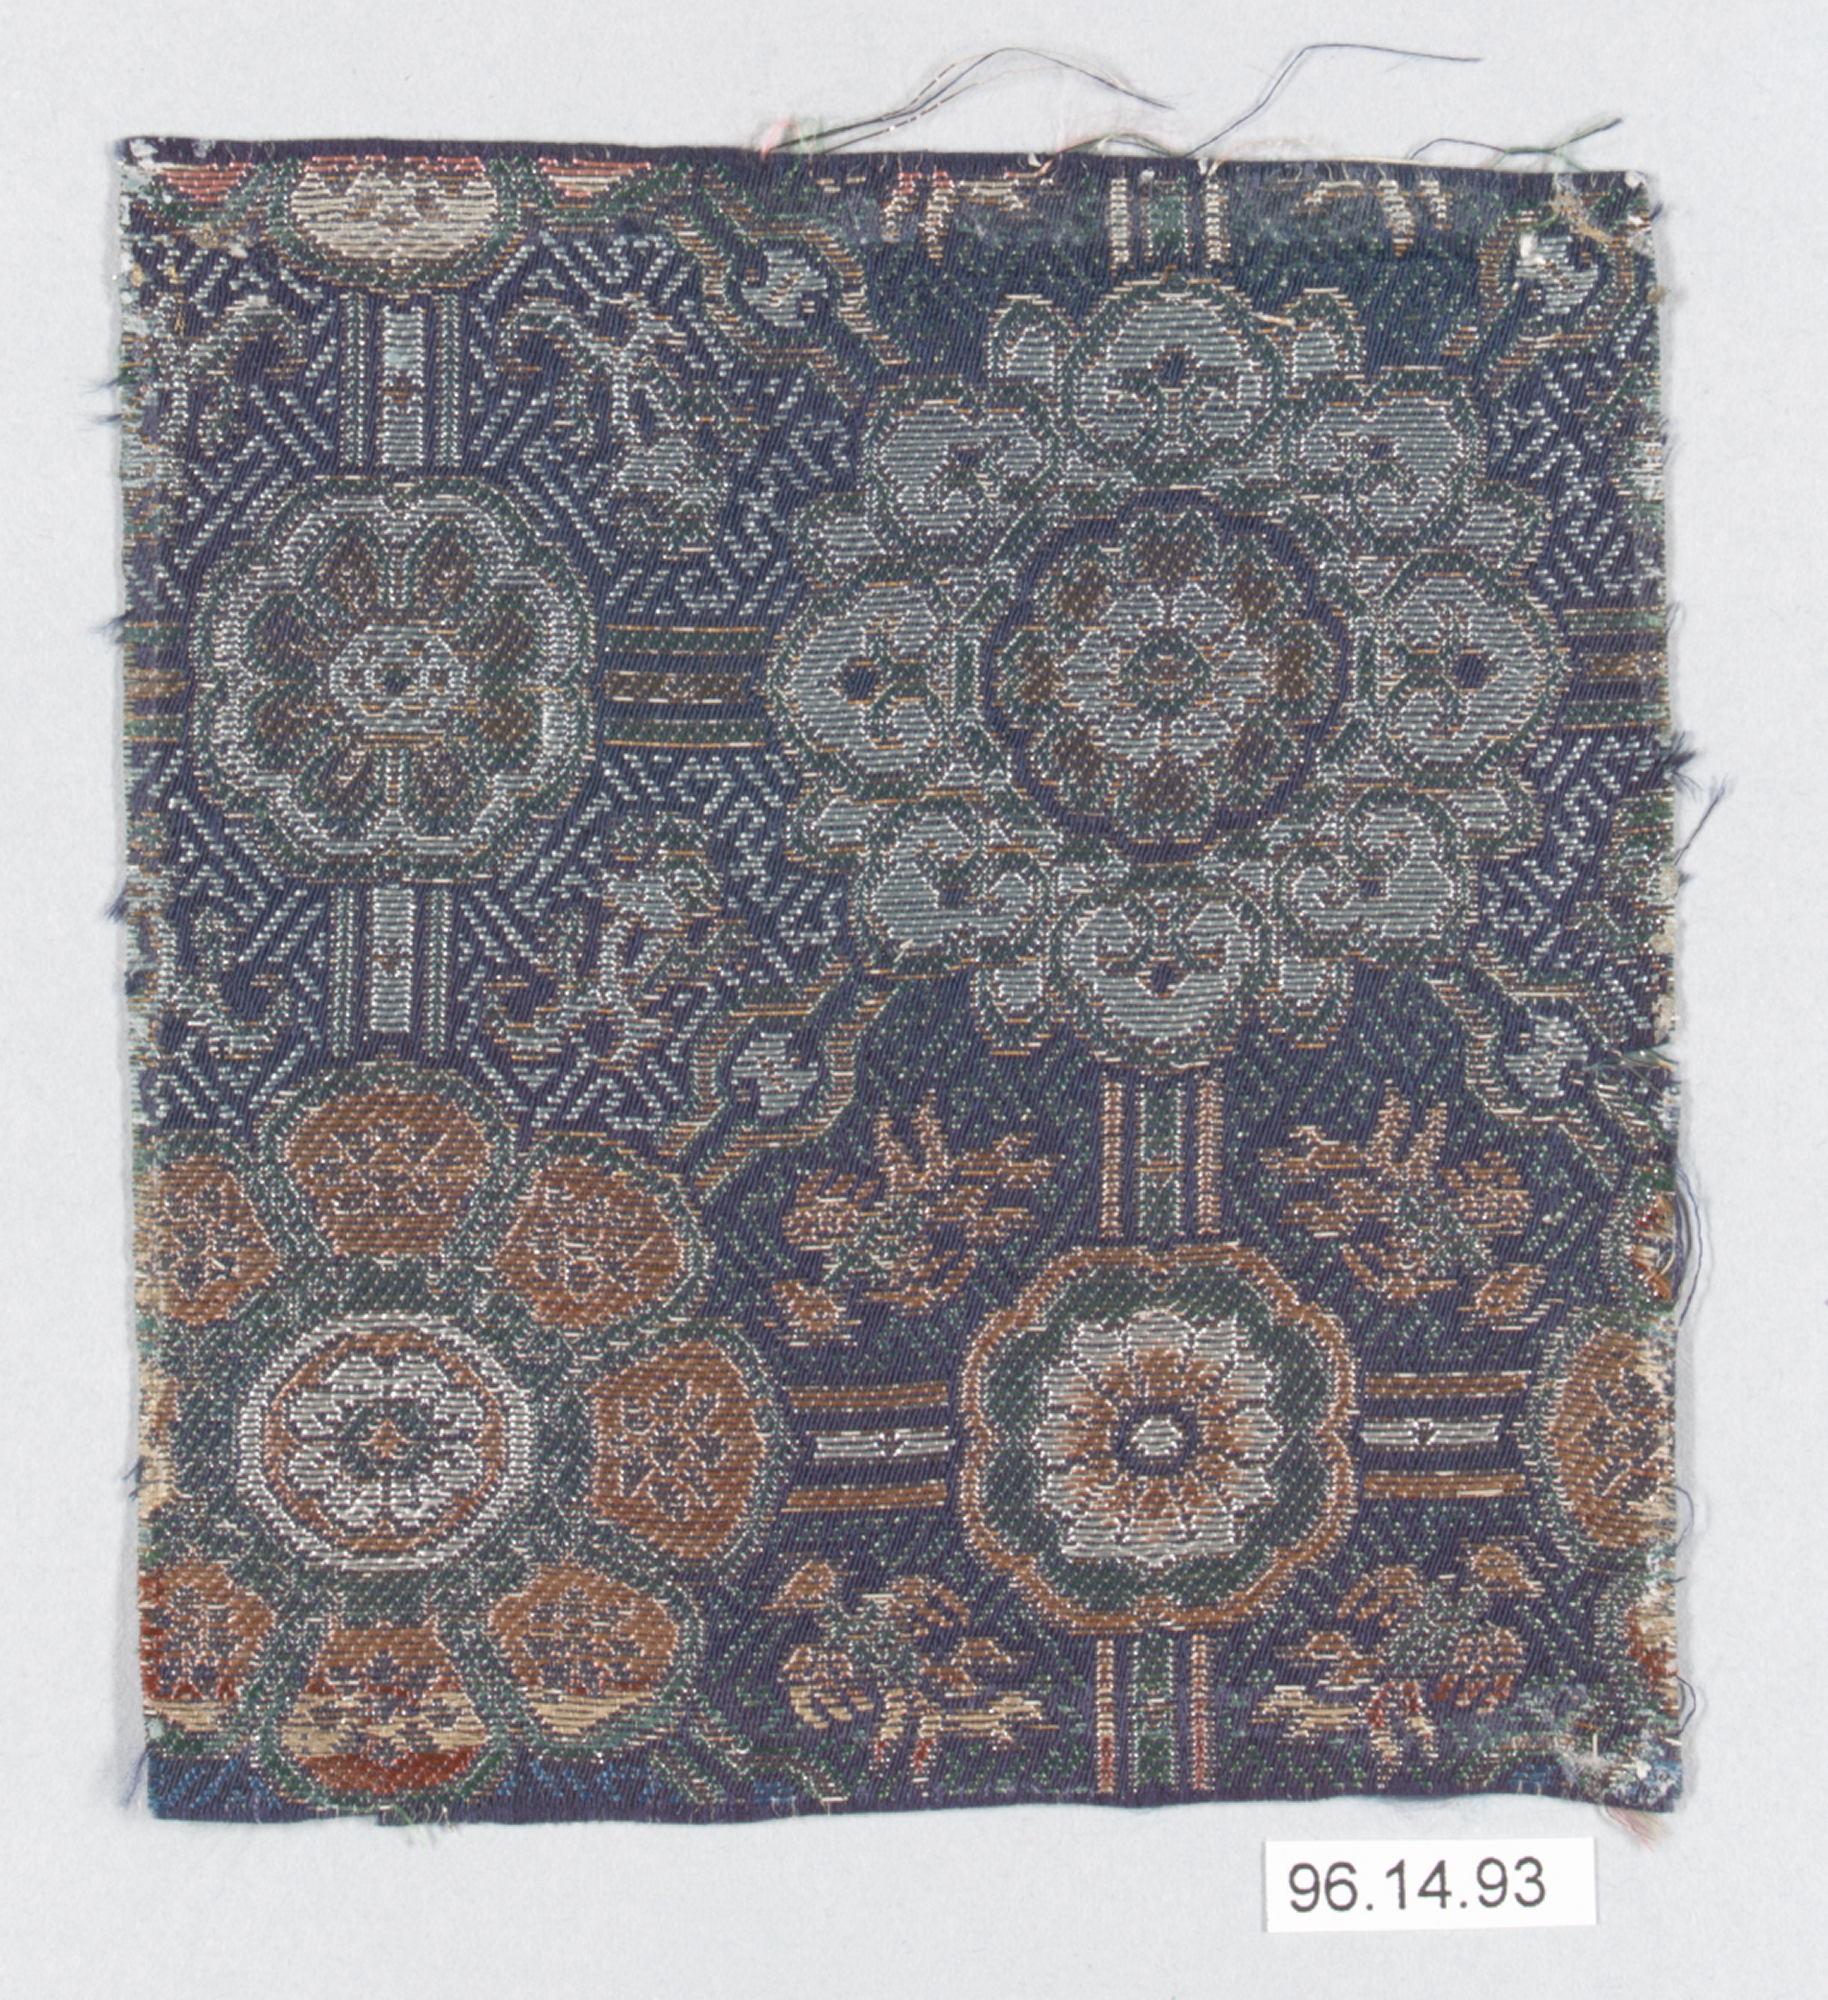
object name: piece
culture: japanese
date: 1701-1900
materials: silk